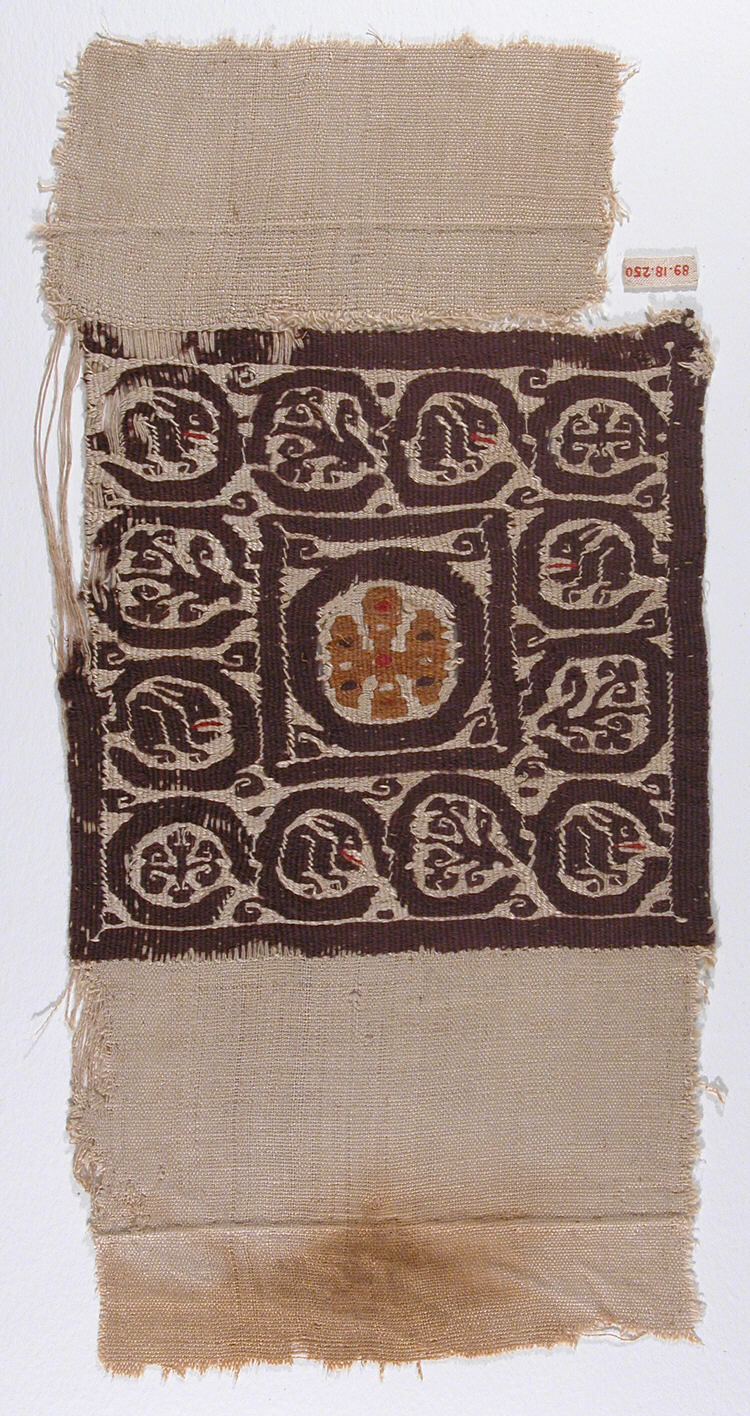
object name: textile fragment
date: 301-400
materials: linen, wool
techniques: weave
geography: egypt